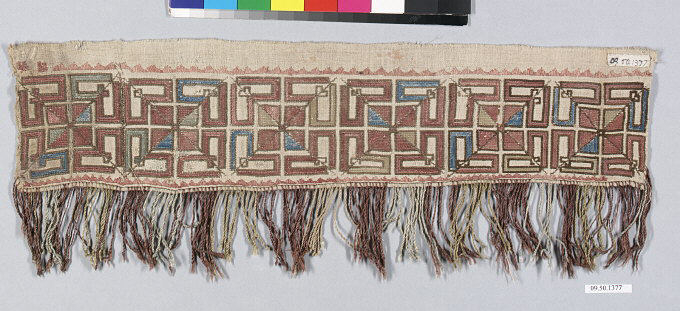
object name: fragment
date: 1701-1800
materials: linen